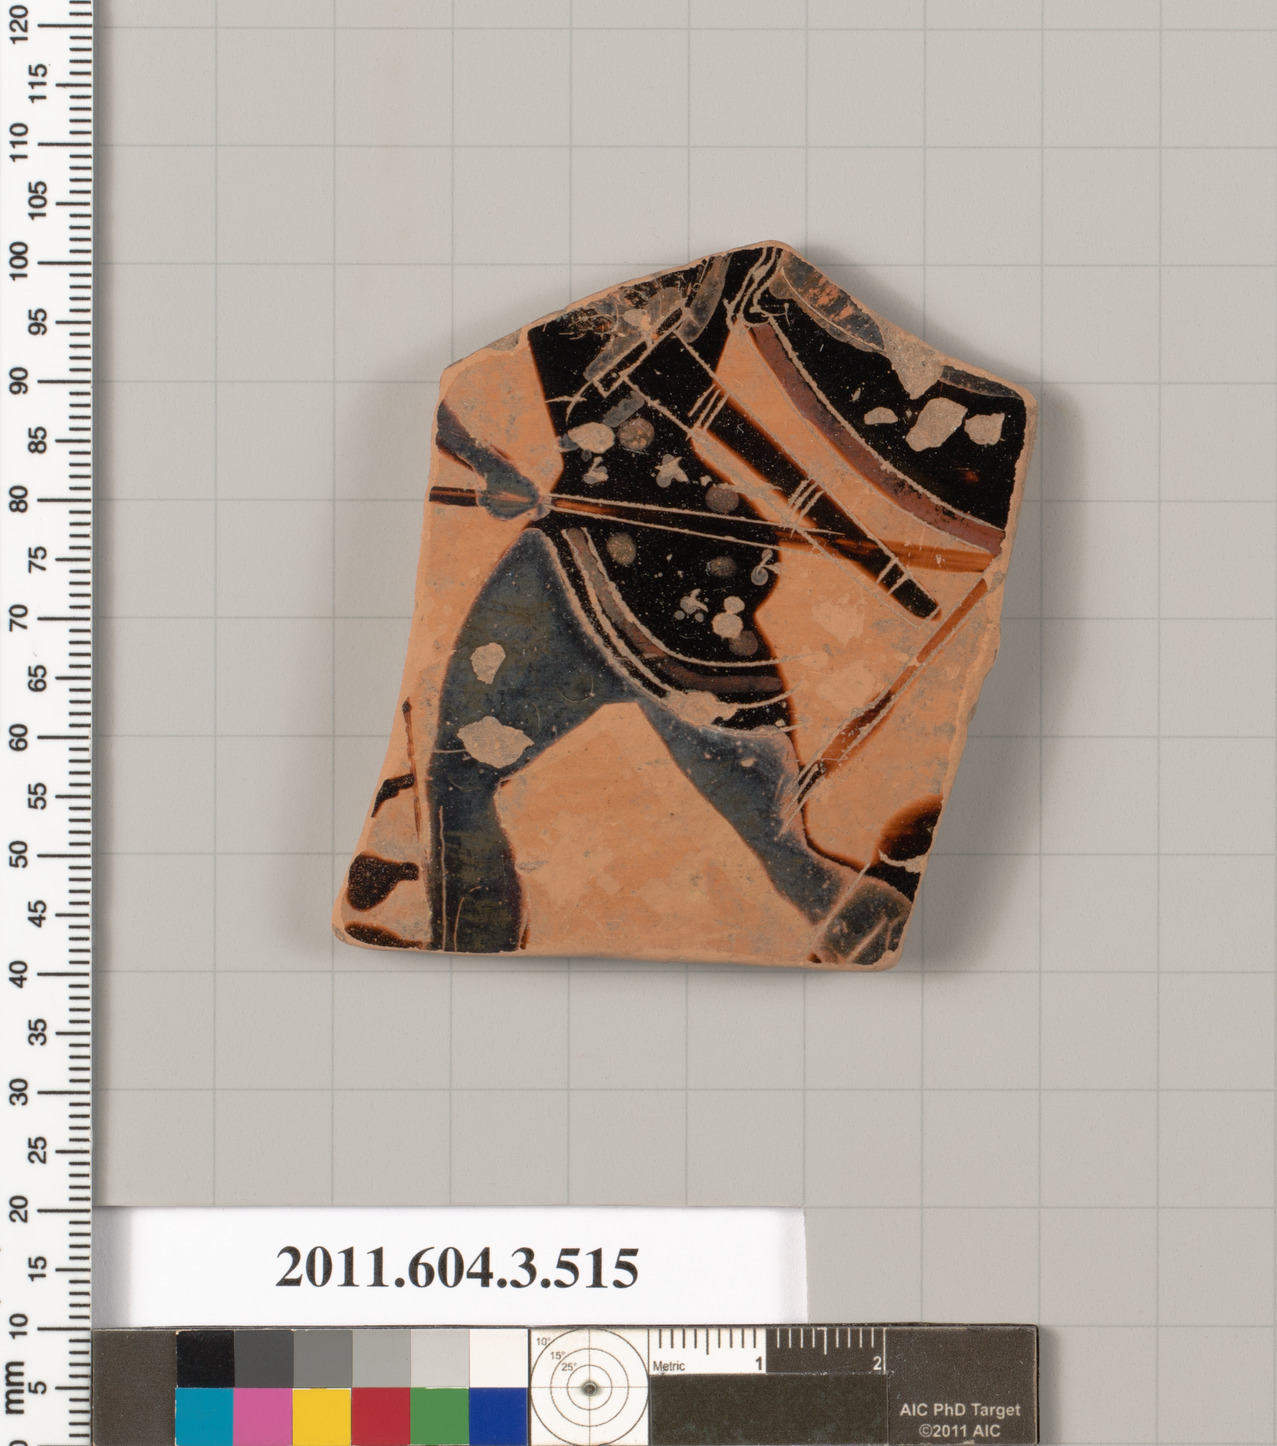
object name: column krater fragment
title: Terracotta fragment of a column-krater (bowl for mixing wine and water)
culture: greek, attic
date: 534-468 BCE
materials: terracotta